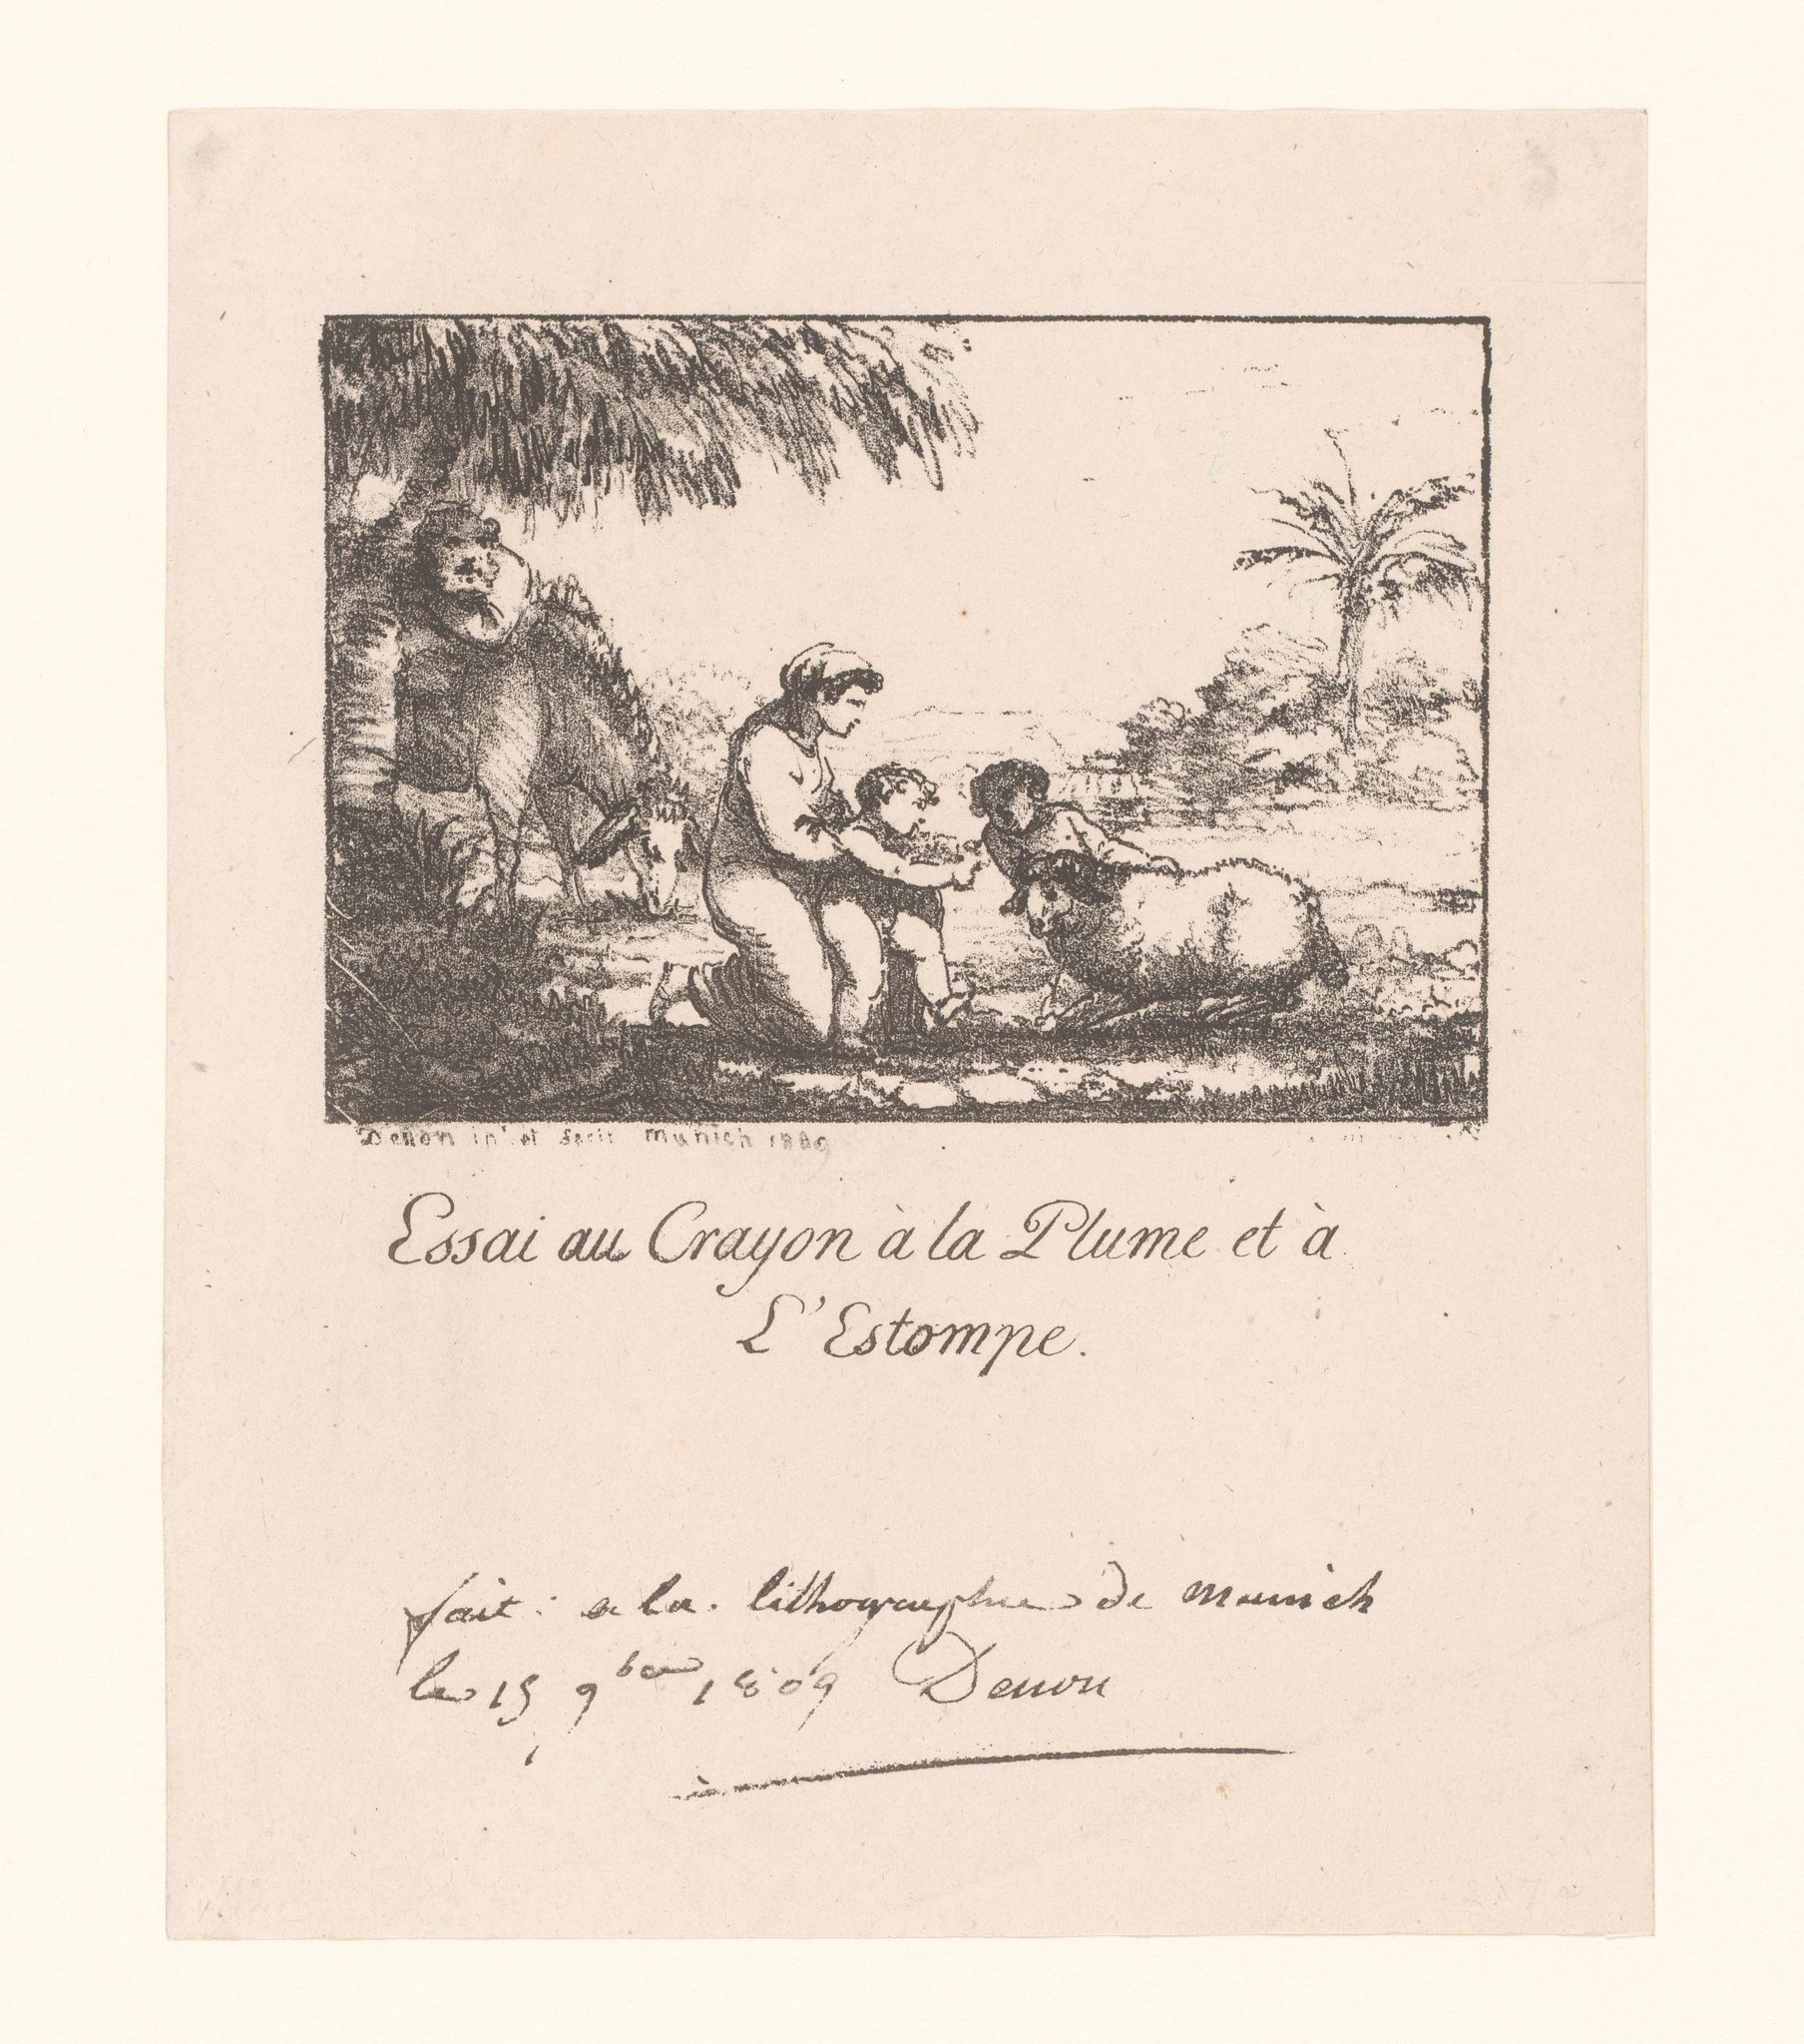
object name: print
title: Heilige Familie met Johannes in Egypte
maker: dominique vivant denon (baron)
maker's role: draughtsman, print maker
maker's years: 1747-1825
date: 1809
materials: paper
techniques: lithograph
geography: munich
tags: holy family, and derived representations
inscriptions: date